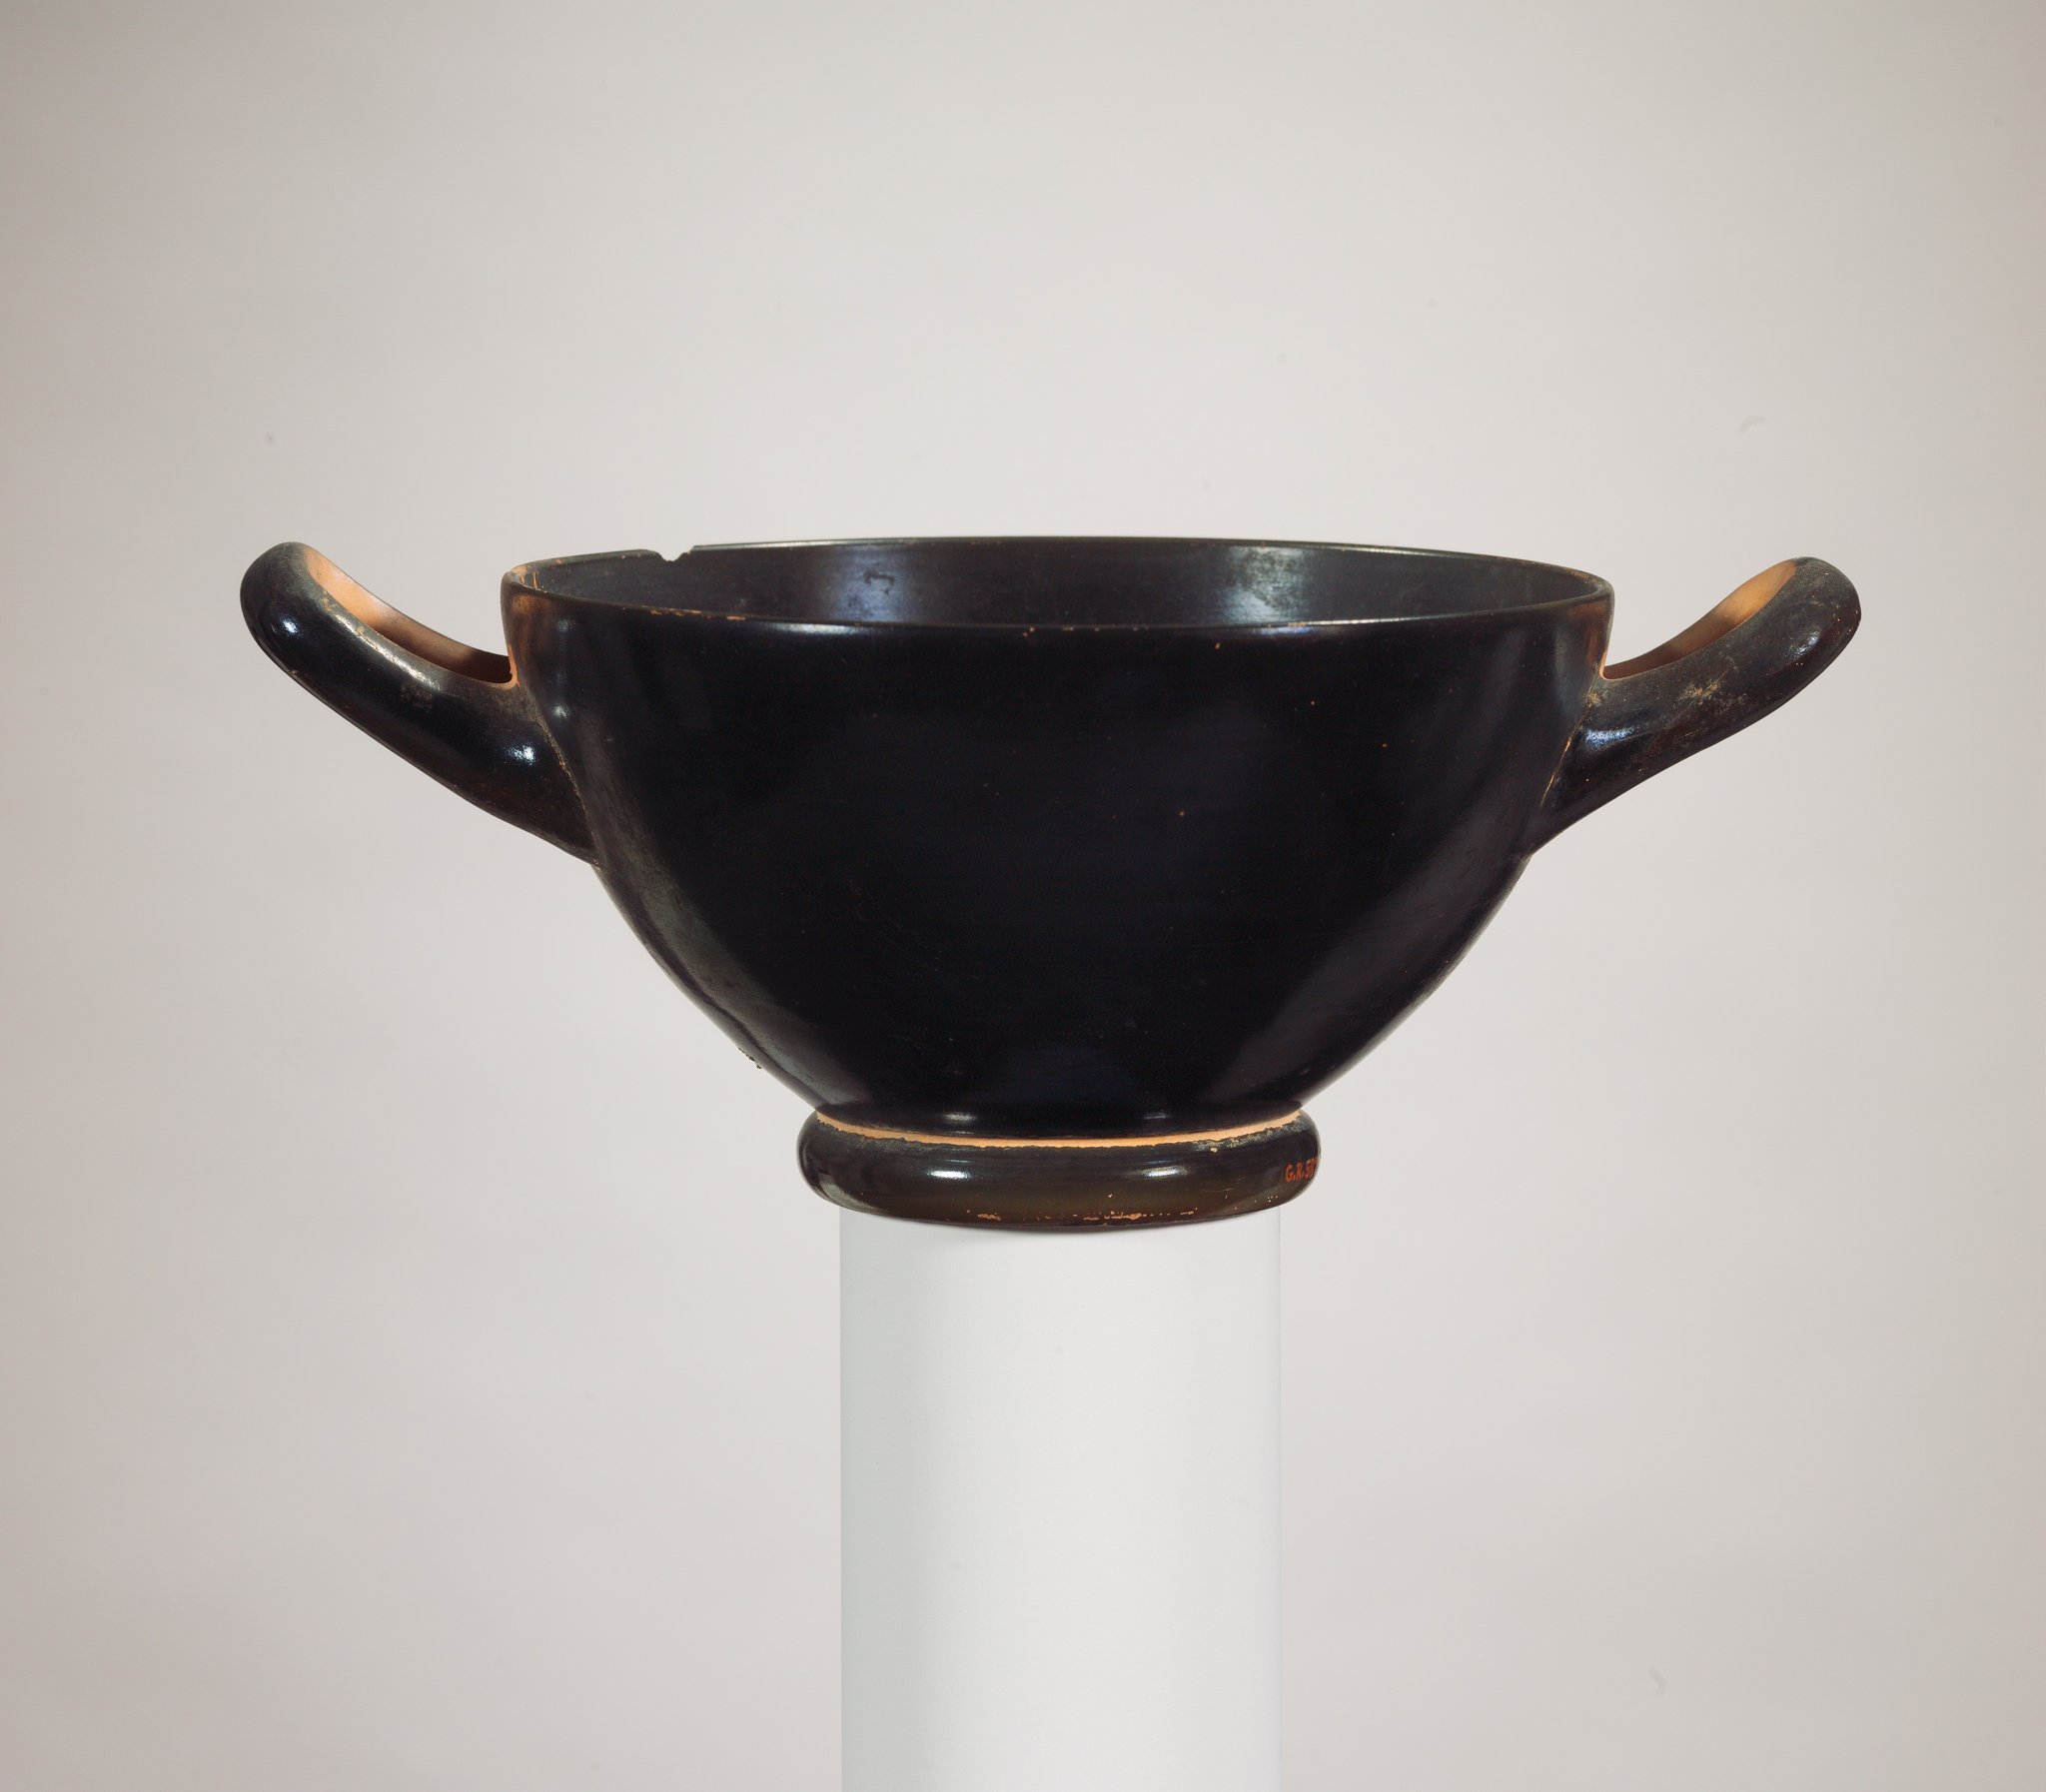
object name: skyphos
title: Terracotta skyphos (deep drinking cup)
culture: greek, attic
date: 475-451 BCE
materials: terracotta